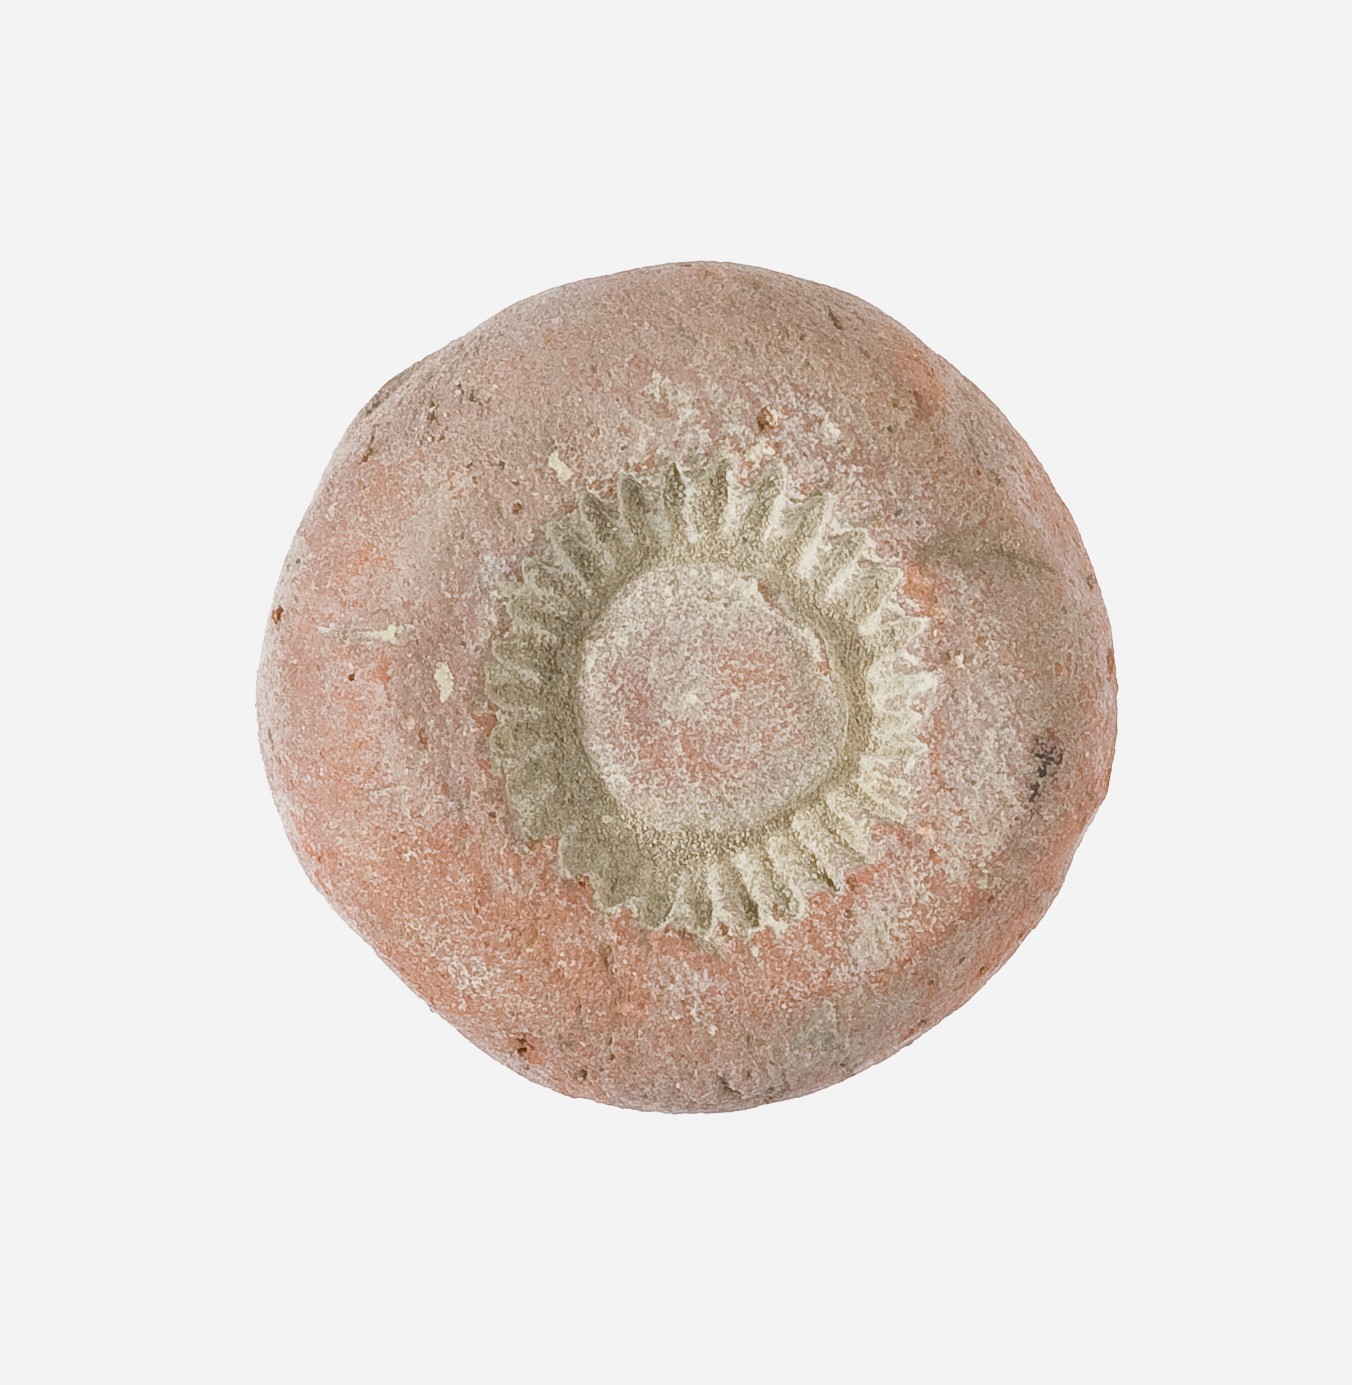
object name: mold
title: Mold for small ring ornaments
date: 1390-1352 BCE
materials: pottery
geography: egypt